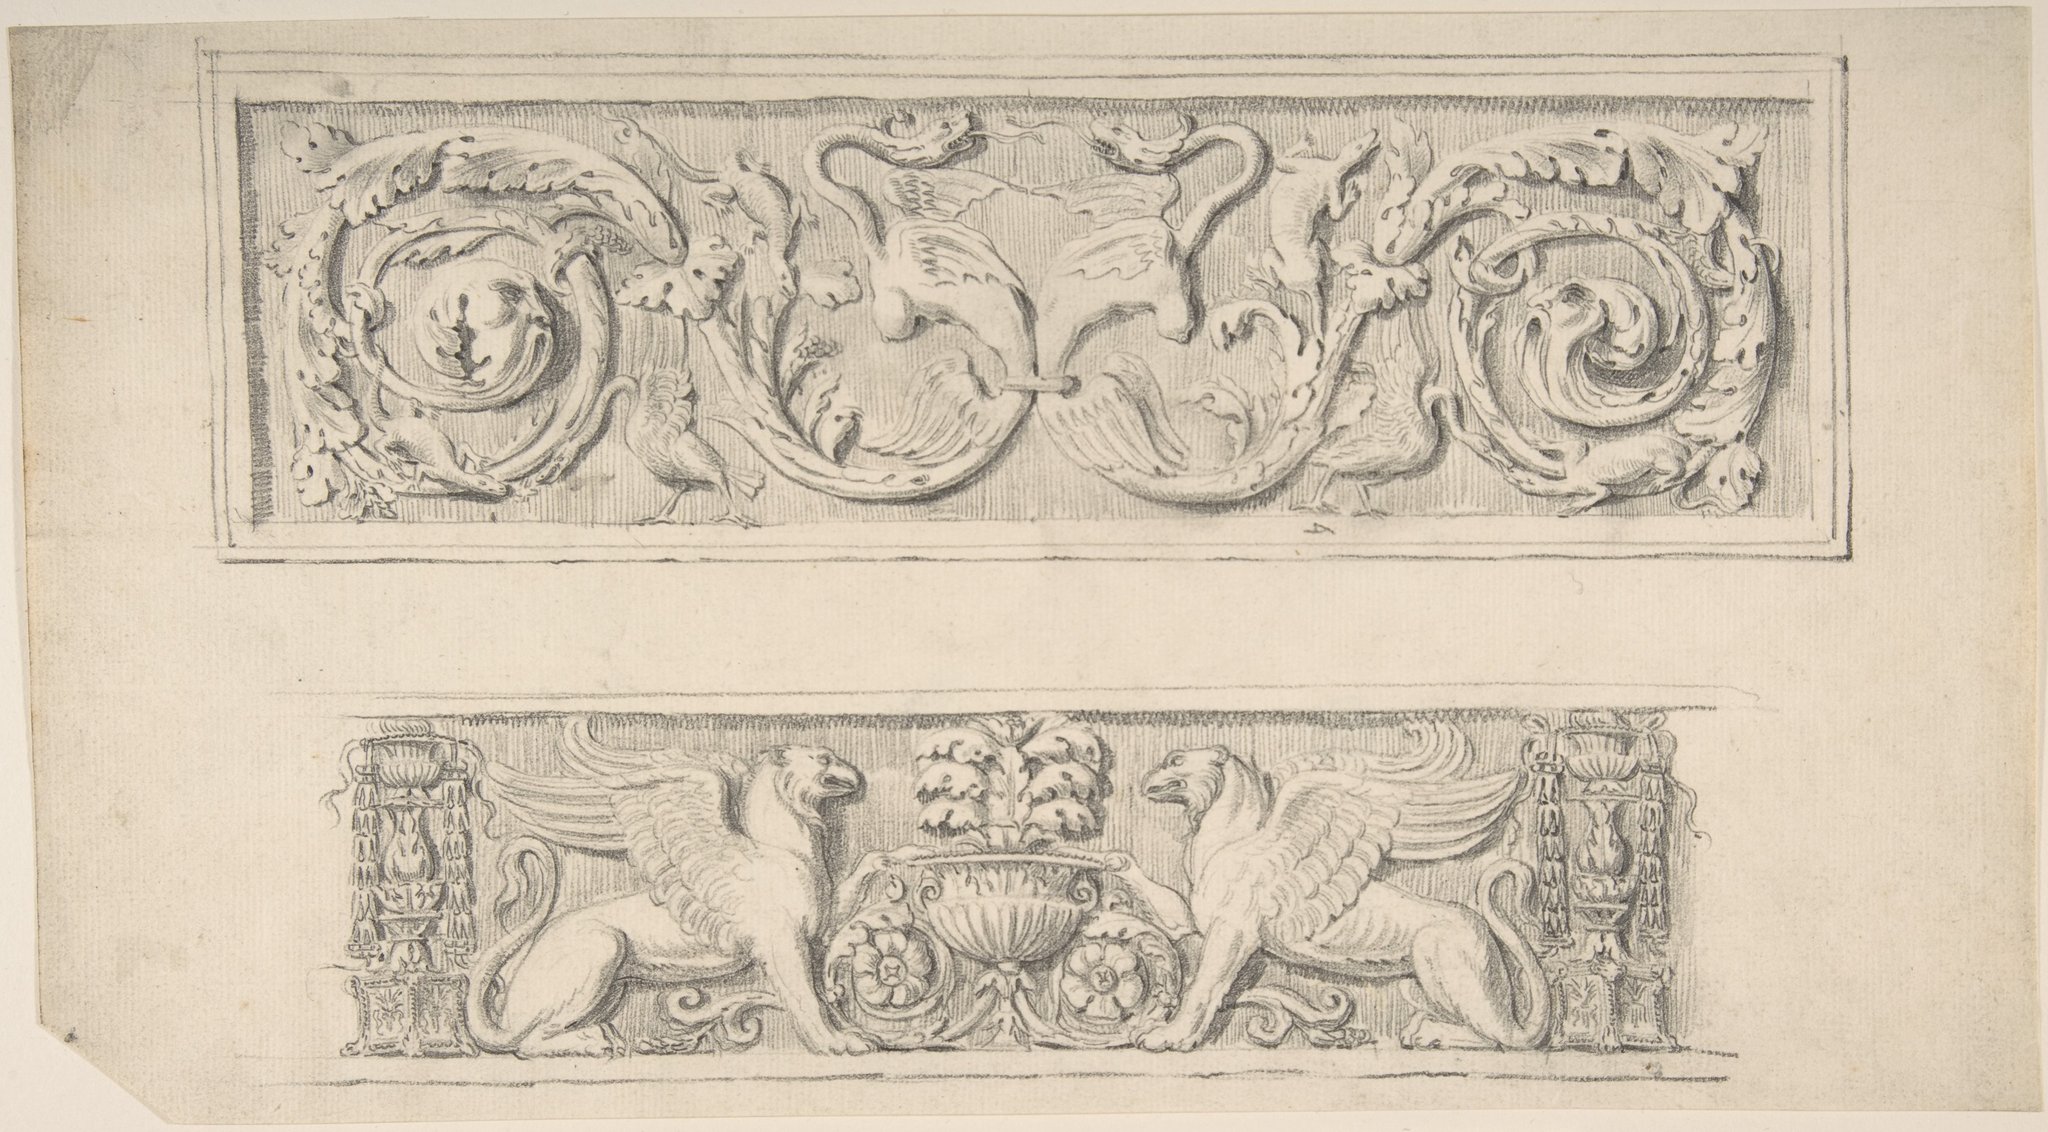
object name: drawing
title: Two Frieze Designs: Decorated with Birds, Reptiles and Vines, Griffins and Vases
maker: thomas hardwick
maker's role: artist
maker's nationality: british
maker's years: 1752-1829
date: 1776-1779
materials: graphite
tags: birds,griffins,vines